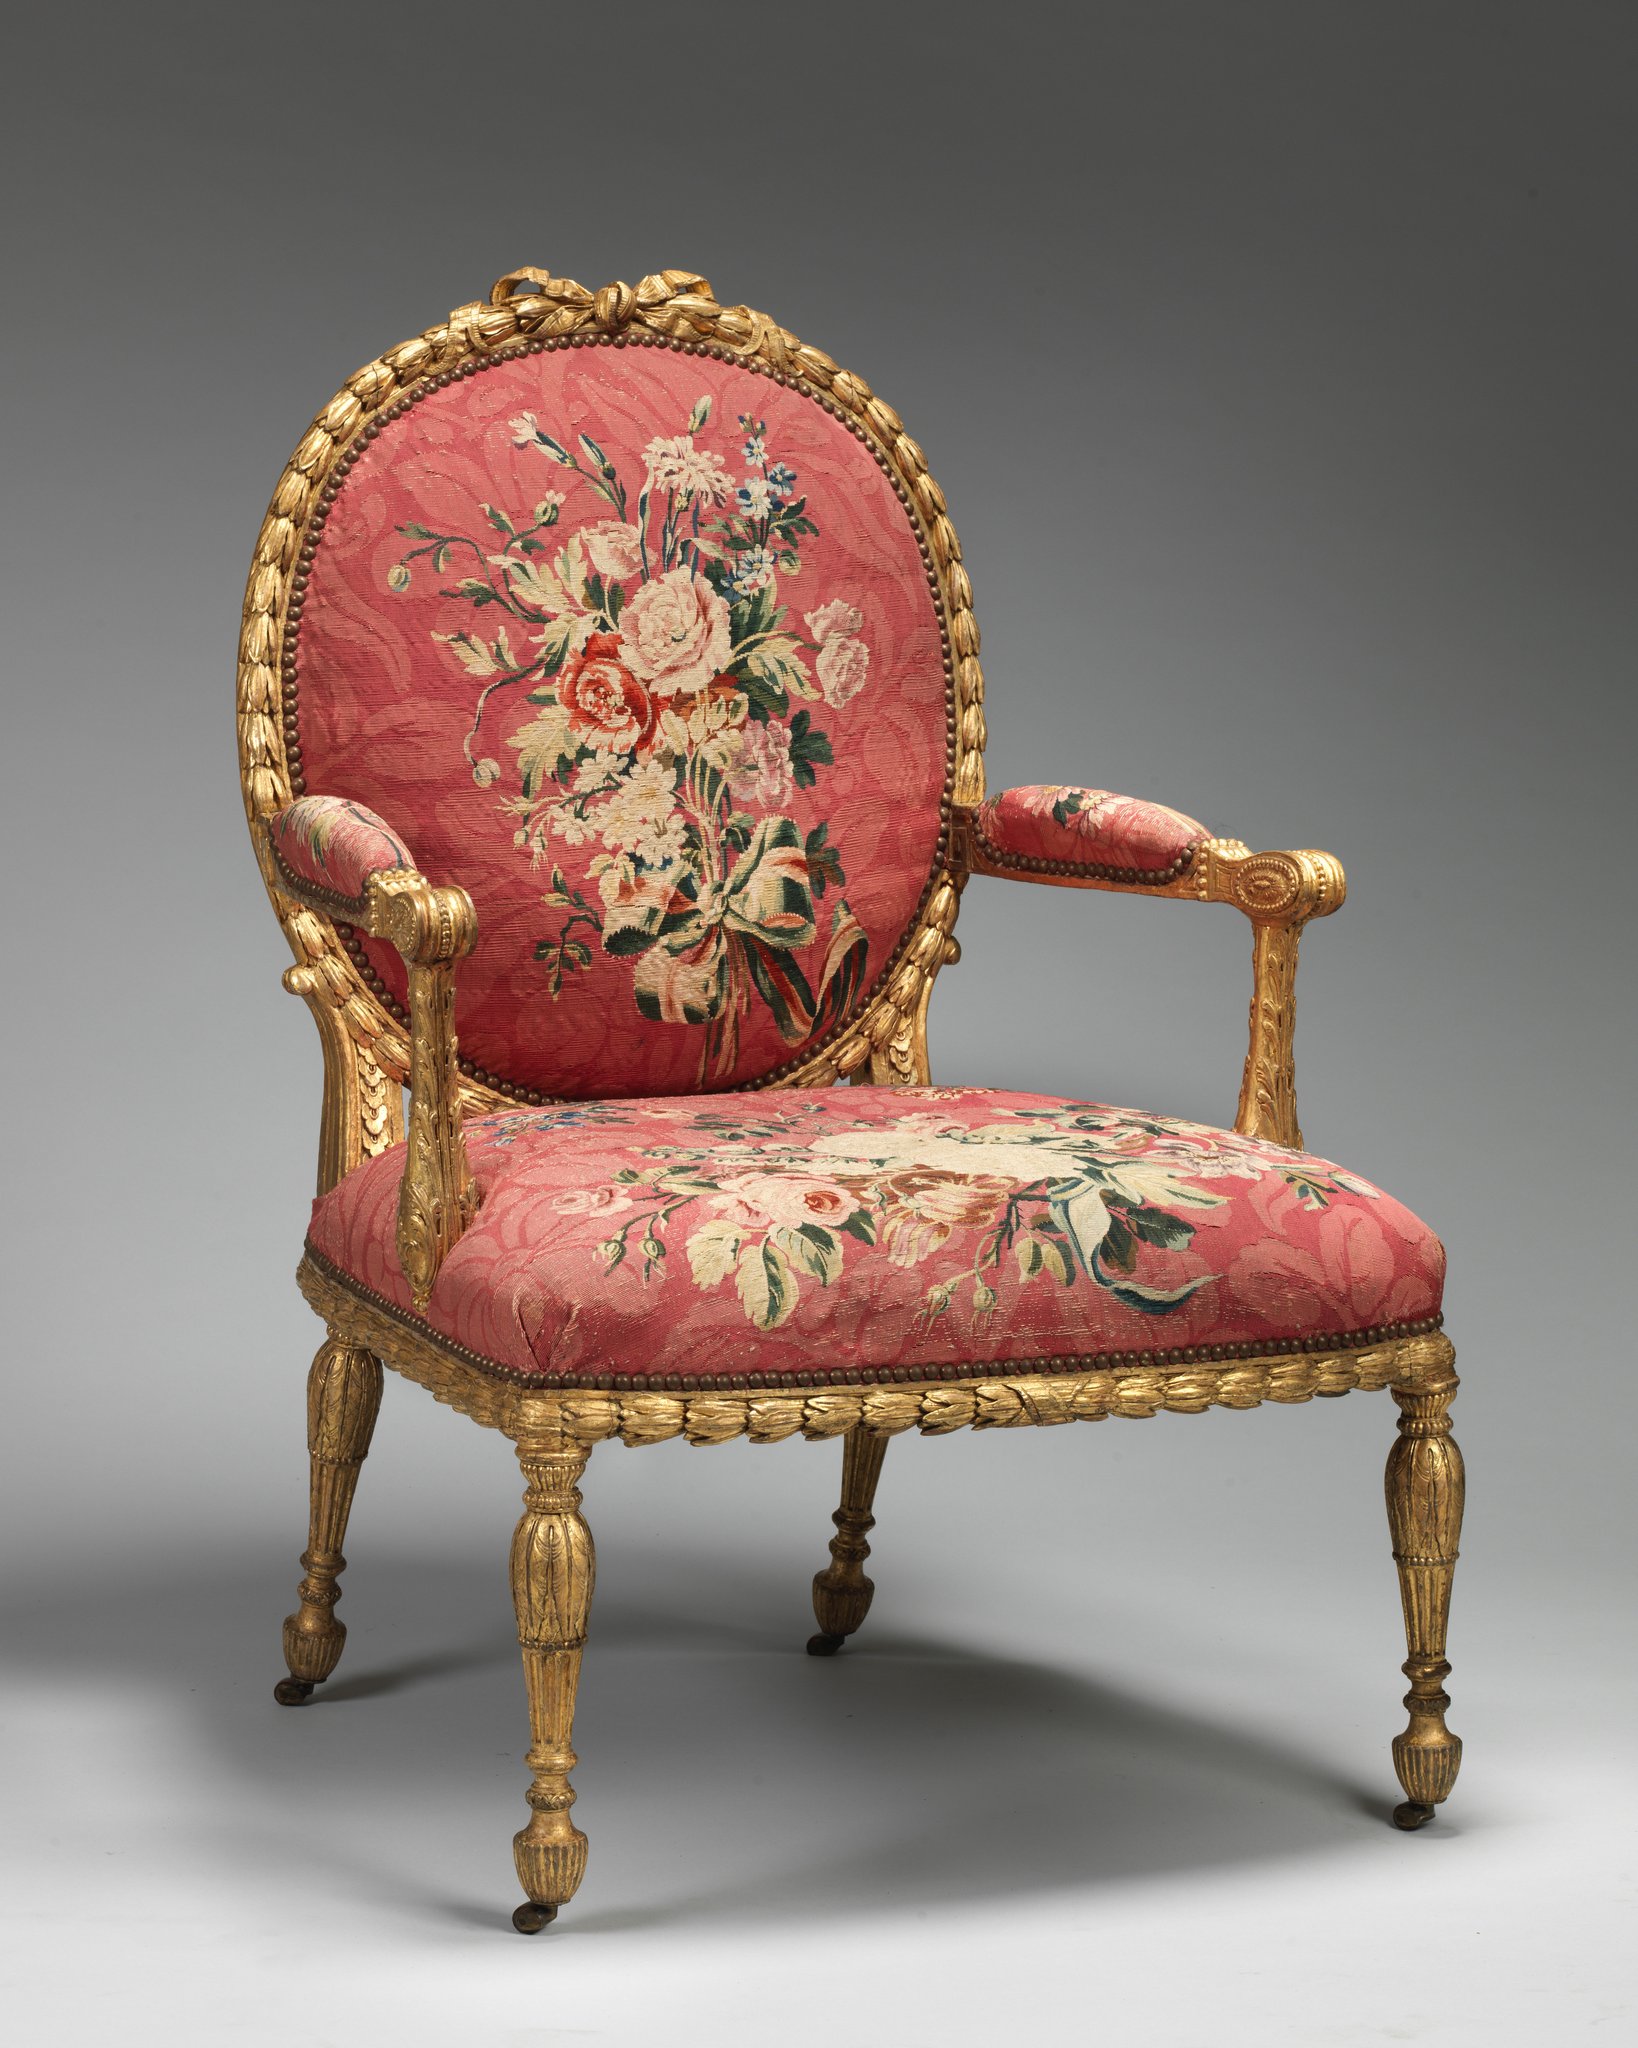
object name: armchair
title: Armchair (one of a set of six)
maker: john mayhew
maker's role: maker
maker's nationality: british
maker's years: 1736-1811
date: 1769-1771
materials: wood, silk, wool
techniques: gilding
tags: flowers